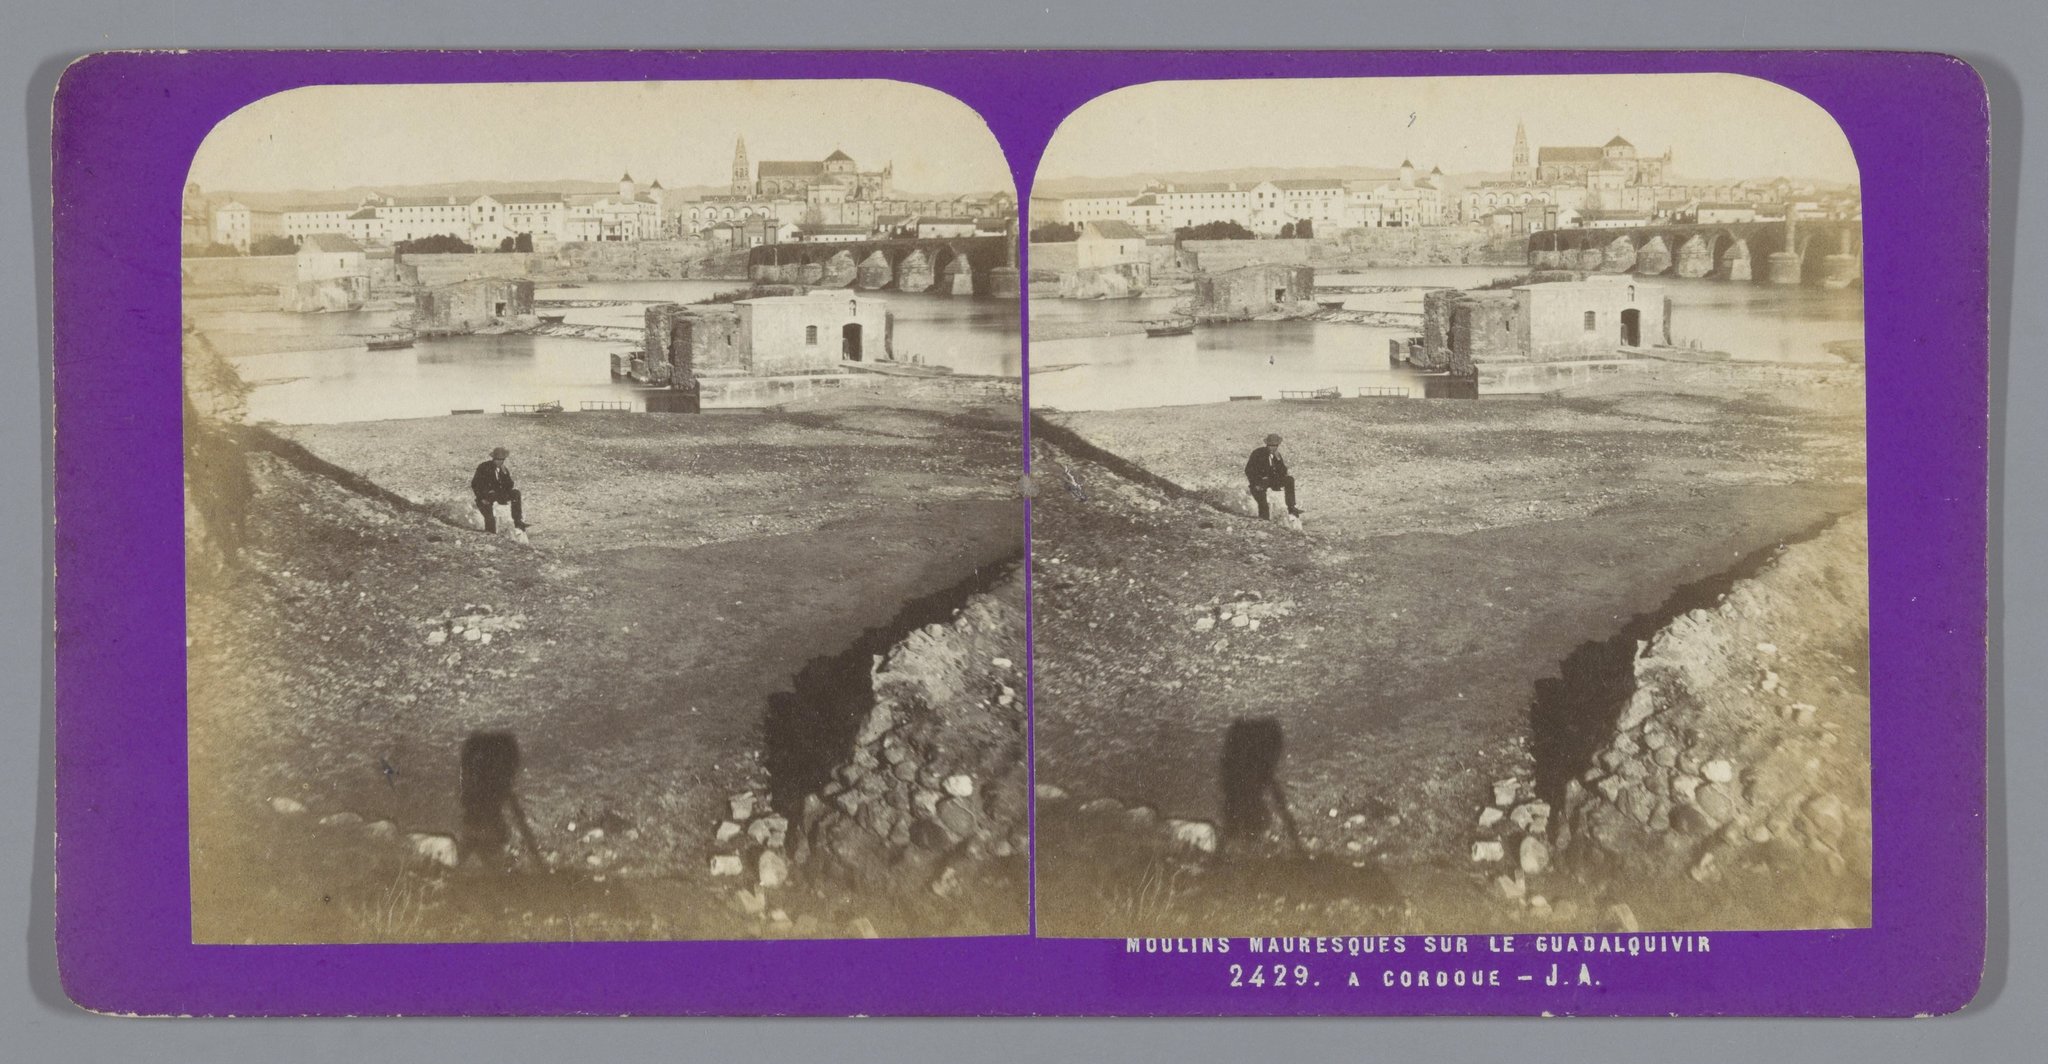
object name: stereograph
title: Gezicht op ruïnes van Moorse molens aan de Guadalquivir bij Córdoba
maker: jean andrieu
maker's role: fotograaf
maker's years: 1816-1872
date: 1862-1876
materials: cardboard, photographic support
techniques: albumen print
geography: córdoba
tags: river, landscape with ruins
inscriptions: number: ‘2429.’